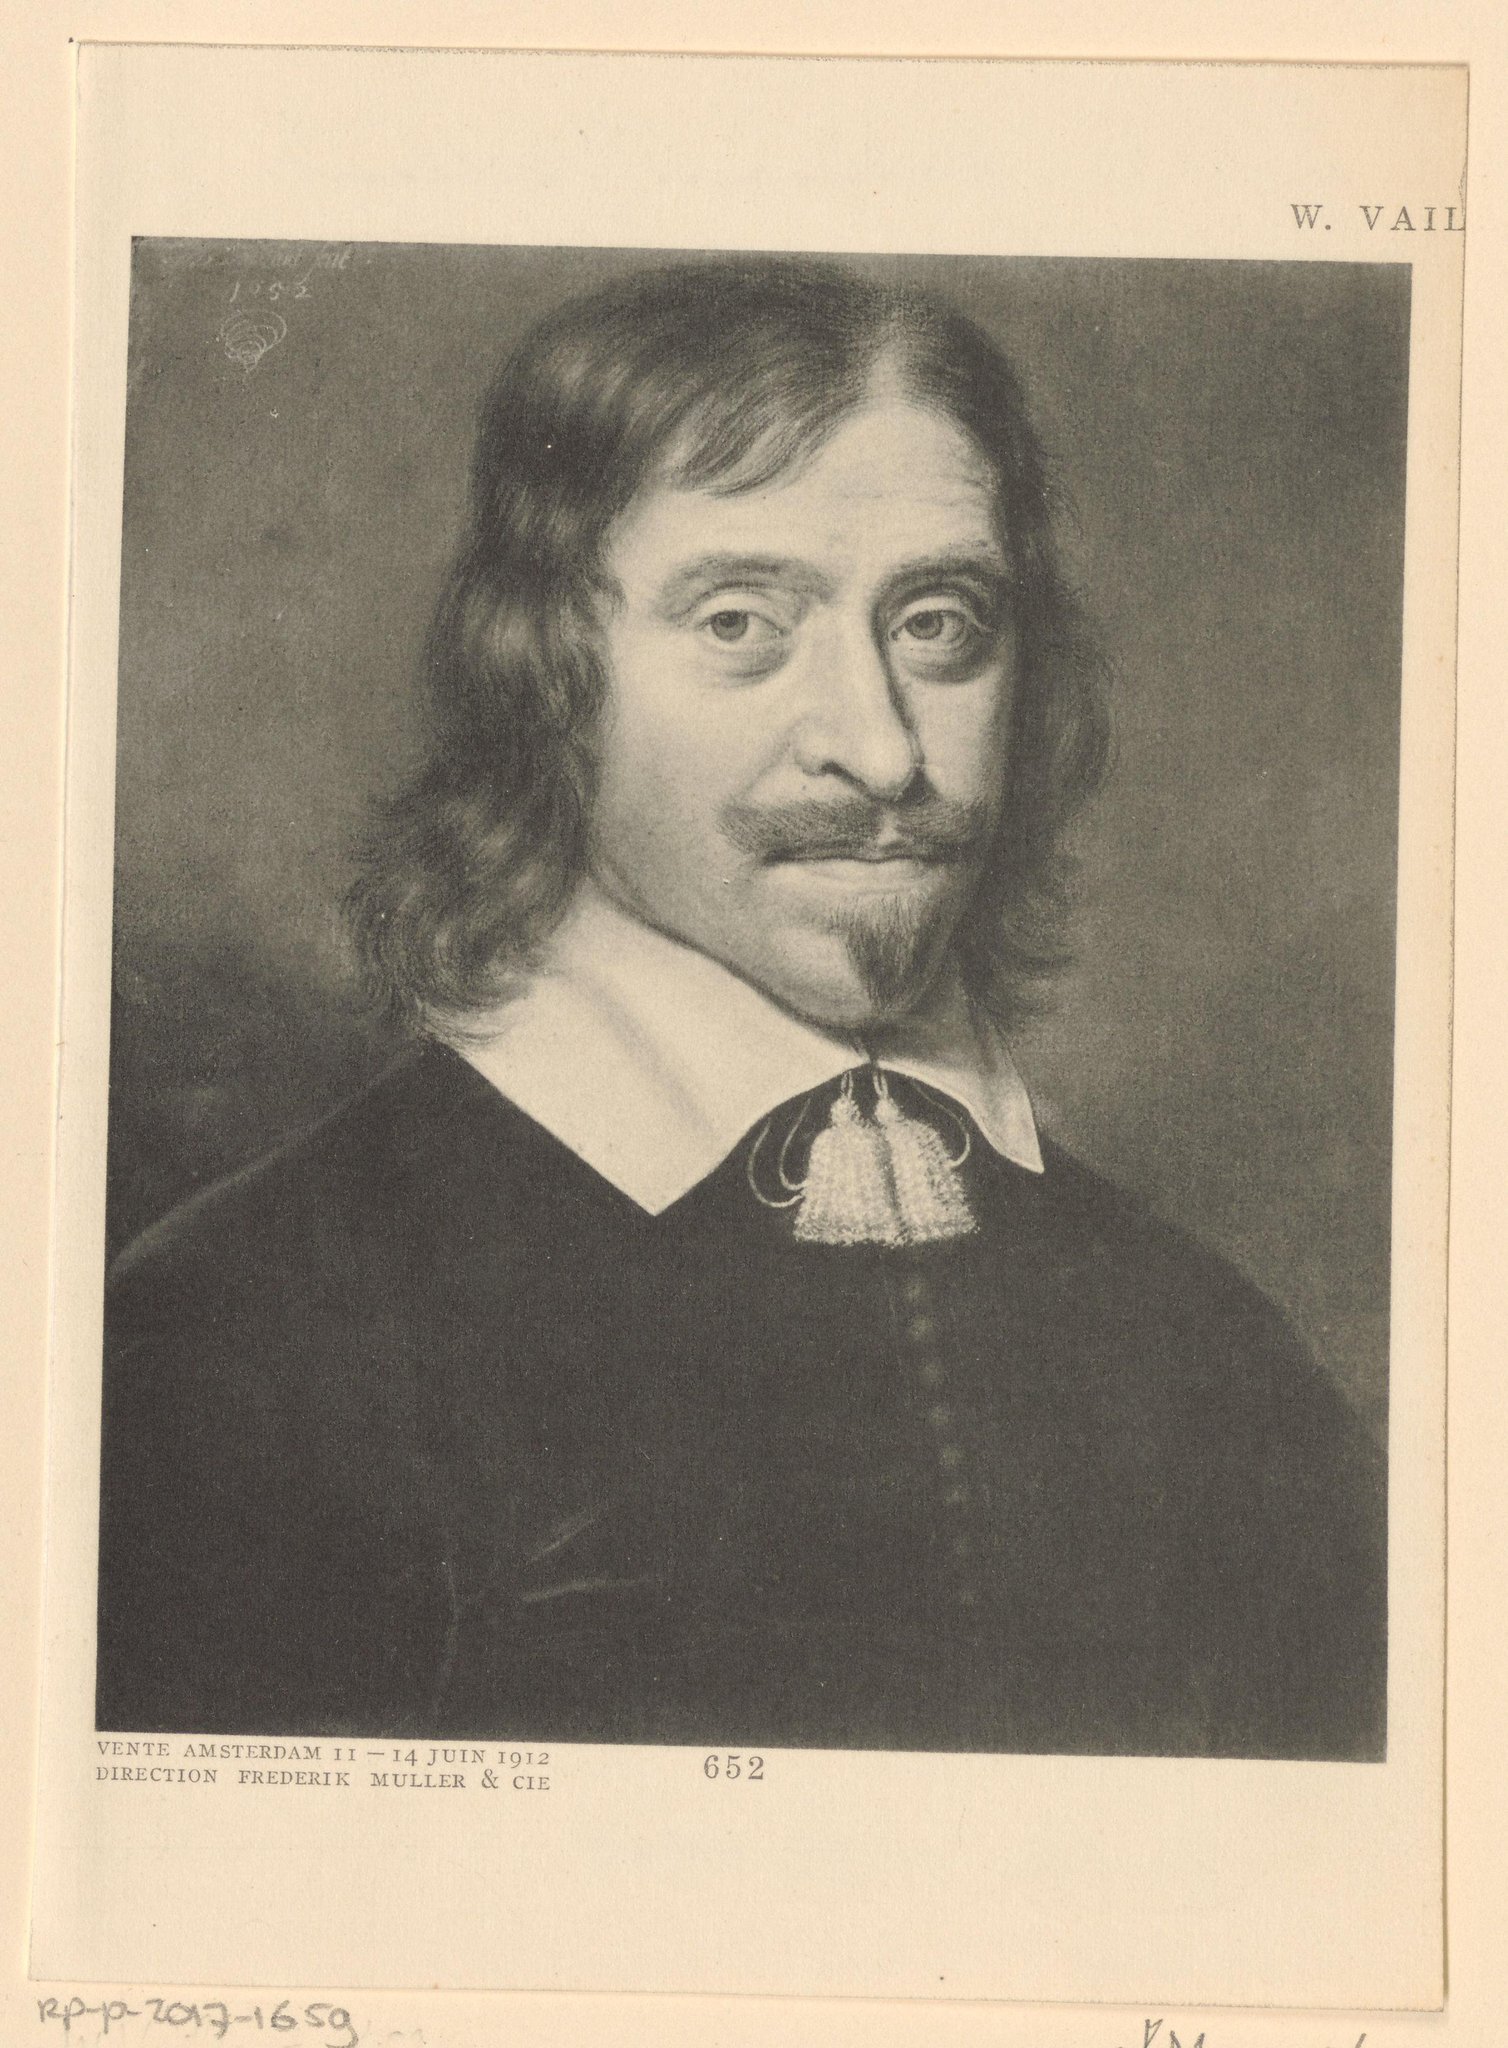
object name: photomechanical print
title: Portret van Frederik Alewijn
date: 1912-1949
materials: paper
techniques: photograph, letterpress printing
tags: amsterdam